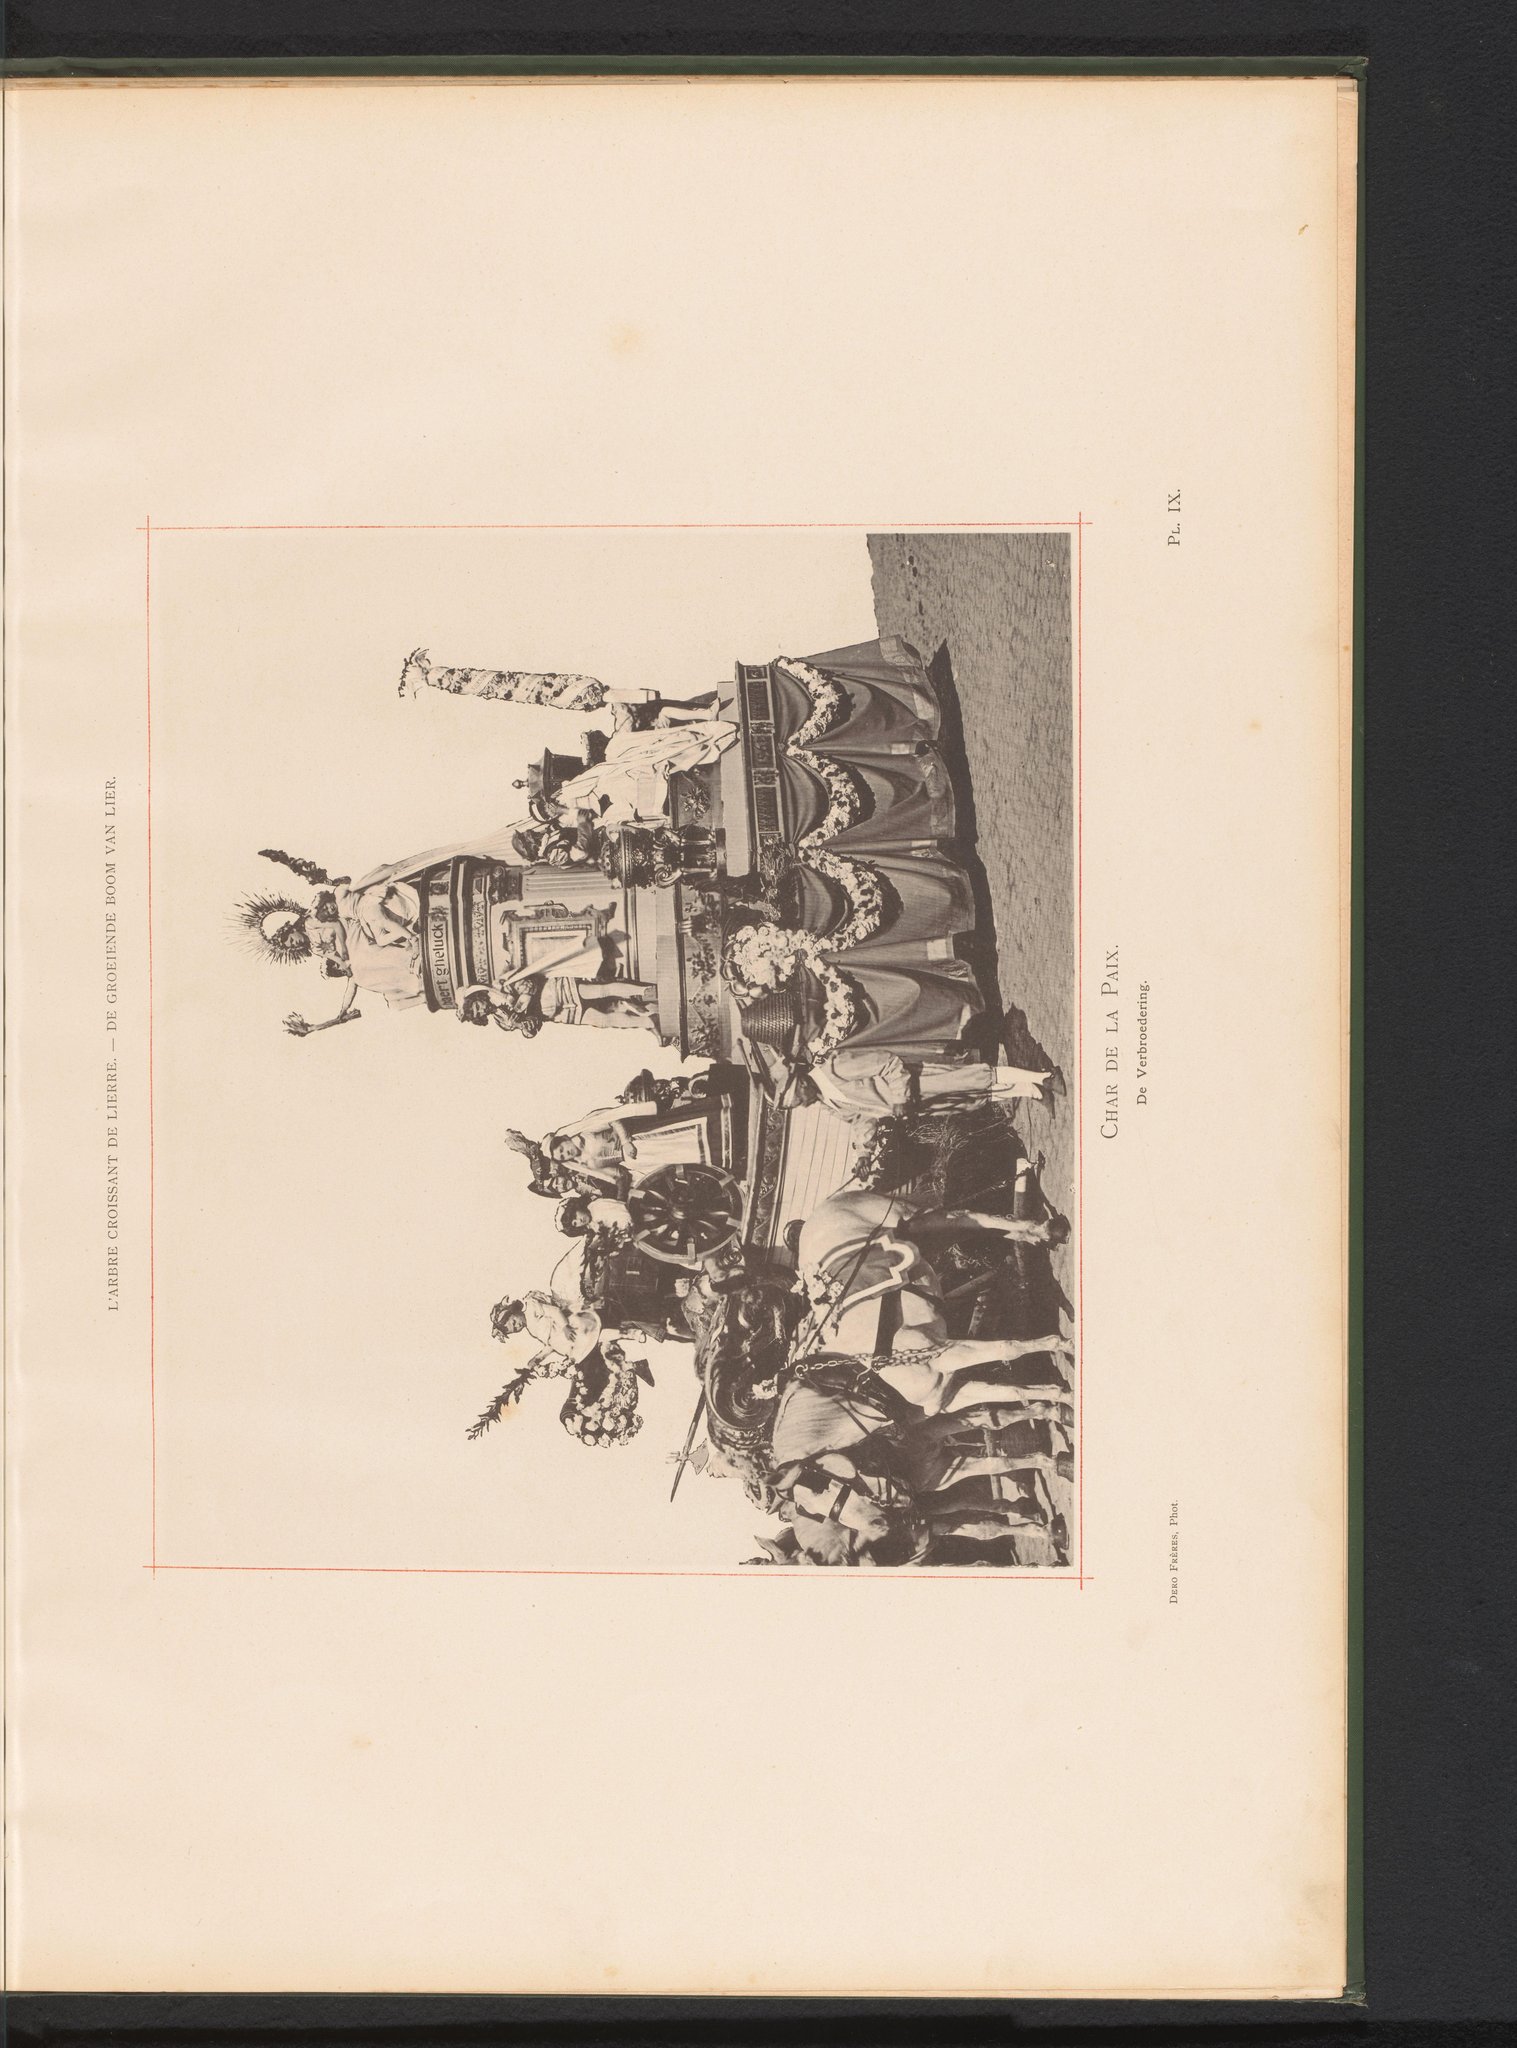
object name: photomechanical print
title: Char de la Paix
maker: joseph maes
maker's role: fotograaf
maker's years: 1838-1908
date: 1892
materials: paper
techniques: photograph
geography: antwerp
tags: public festivities (+ parade, pageant, cavalcade ~ festive activities), antwerp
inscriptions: inscription: ‘L'ARBRE CROISSANT DE LIERRE. - DE GROEIENDE BOOM VAN LIER.’, inscription: ‘De Verbroedering.’, number: ‘Pl. IX.’